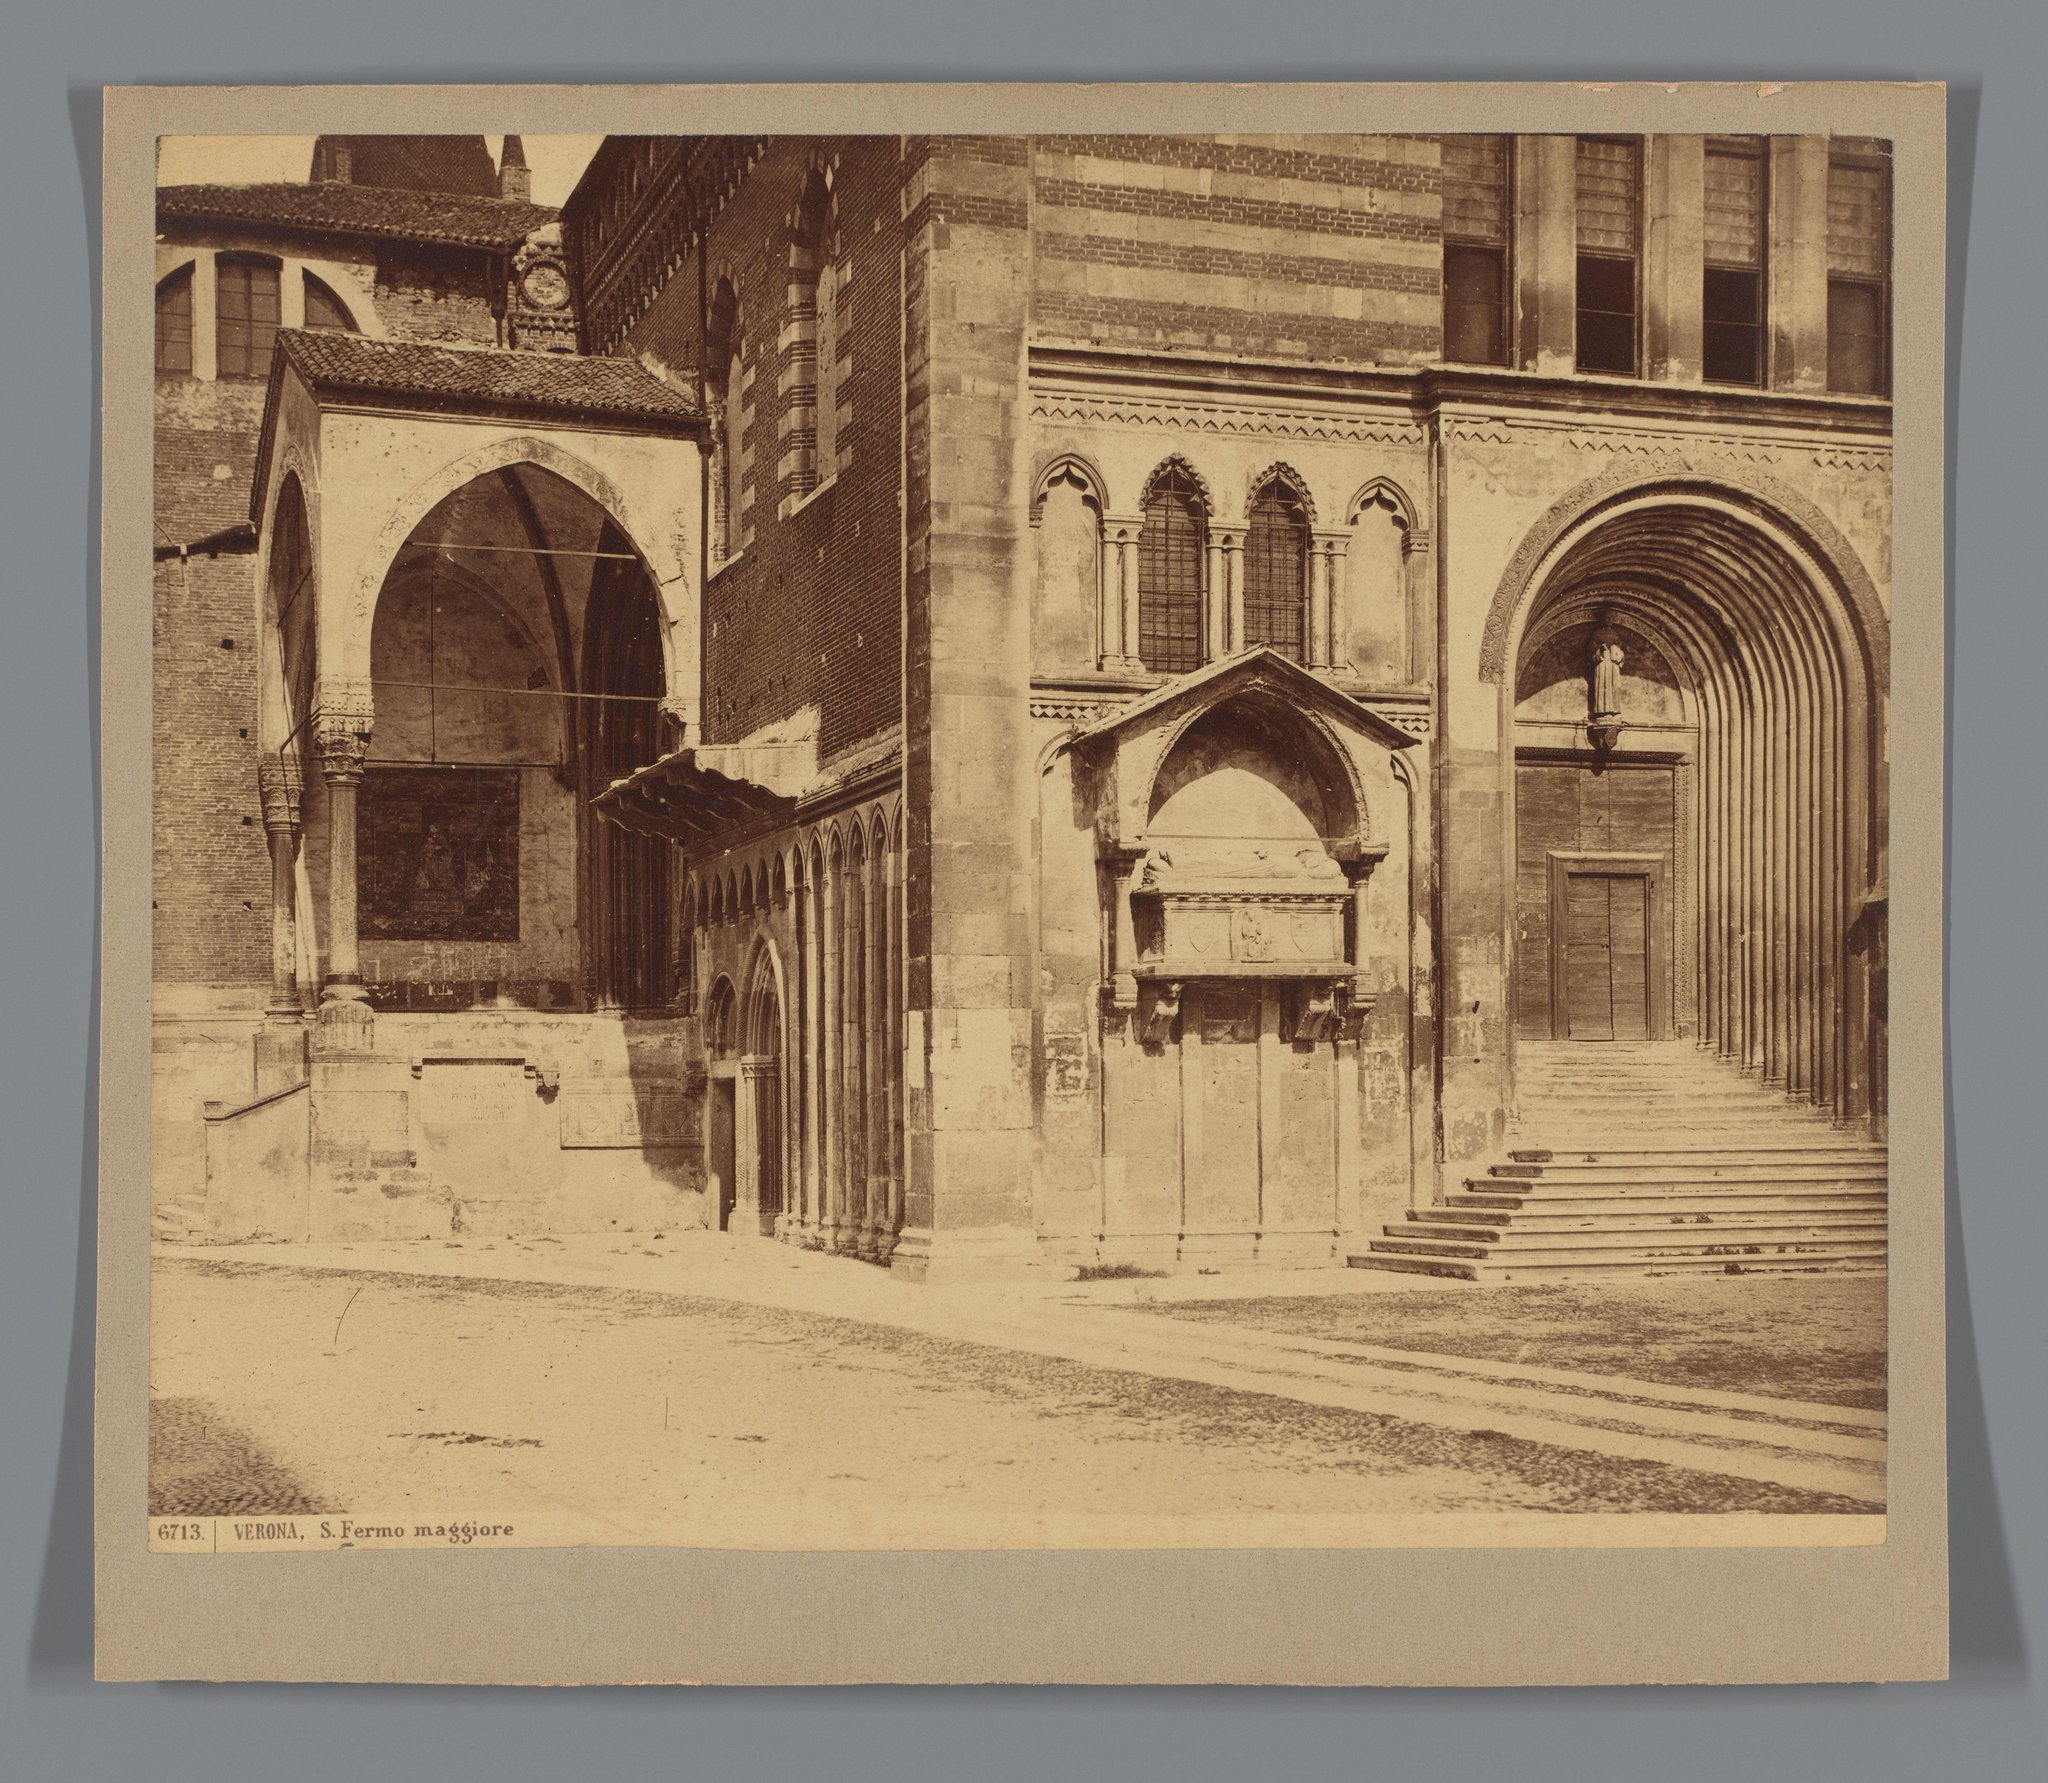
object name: photograph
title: Italië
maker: Anonymous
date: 1880-1910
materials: photographic support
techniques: albumen print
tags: italy